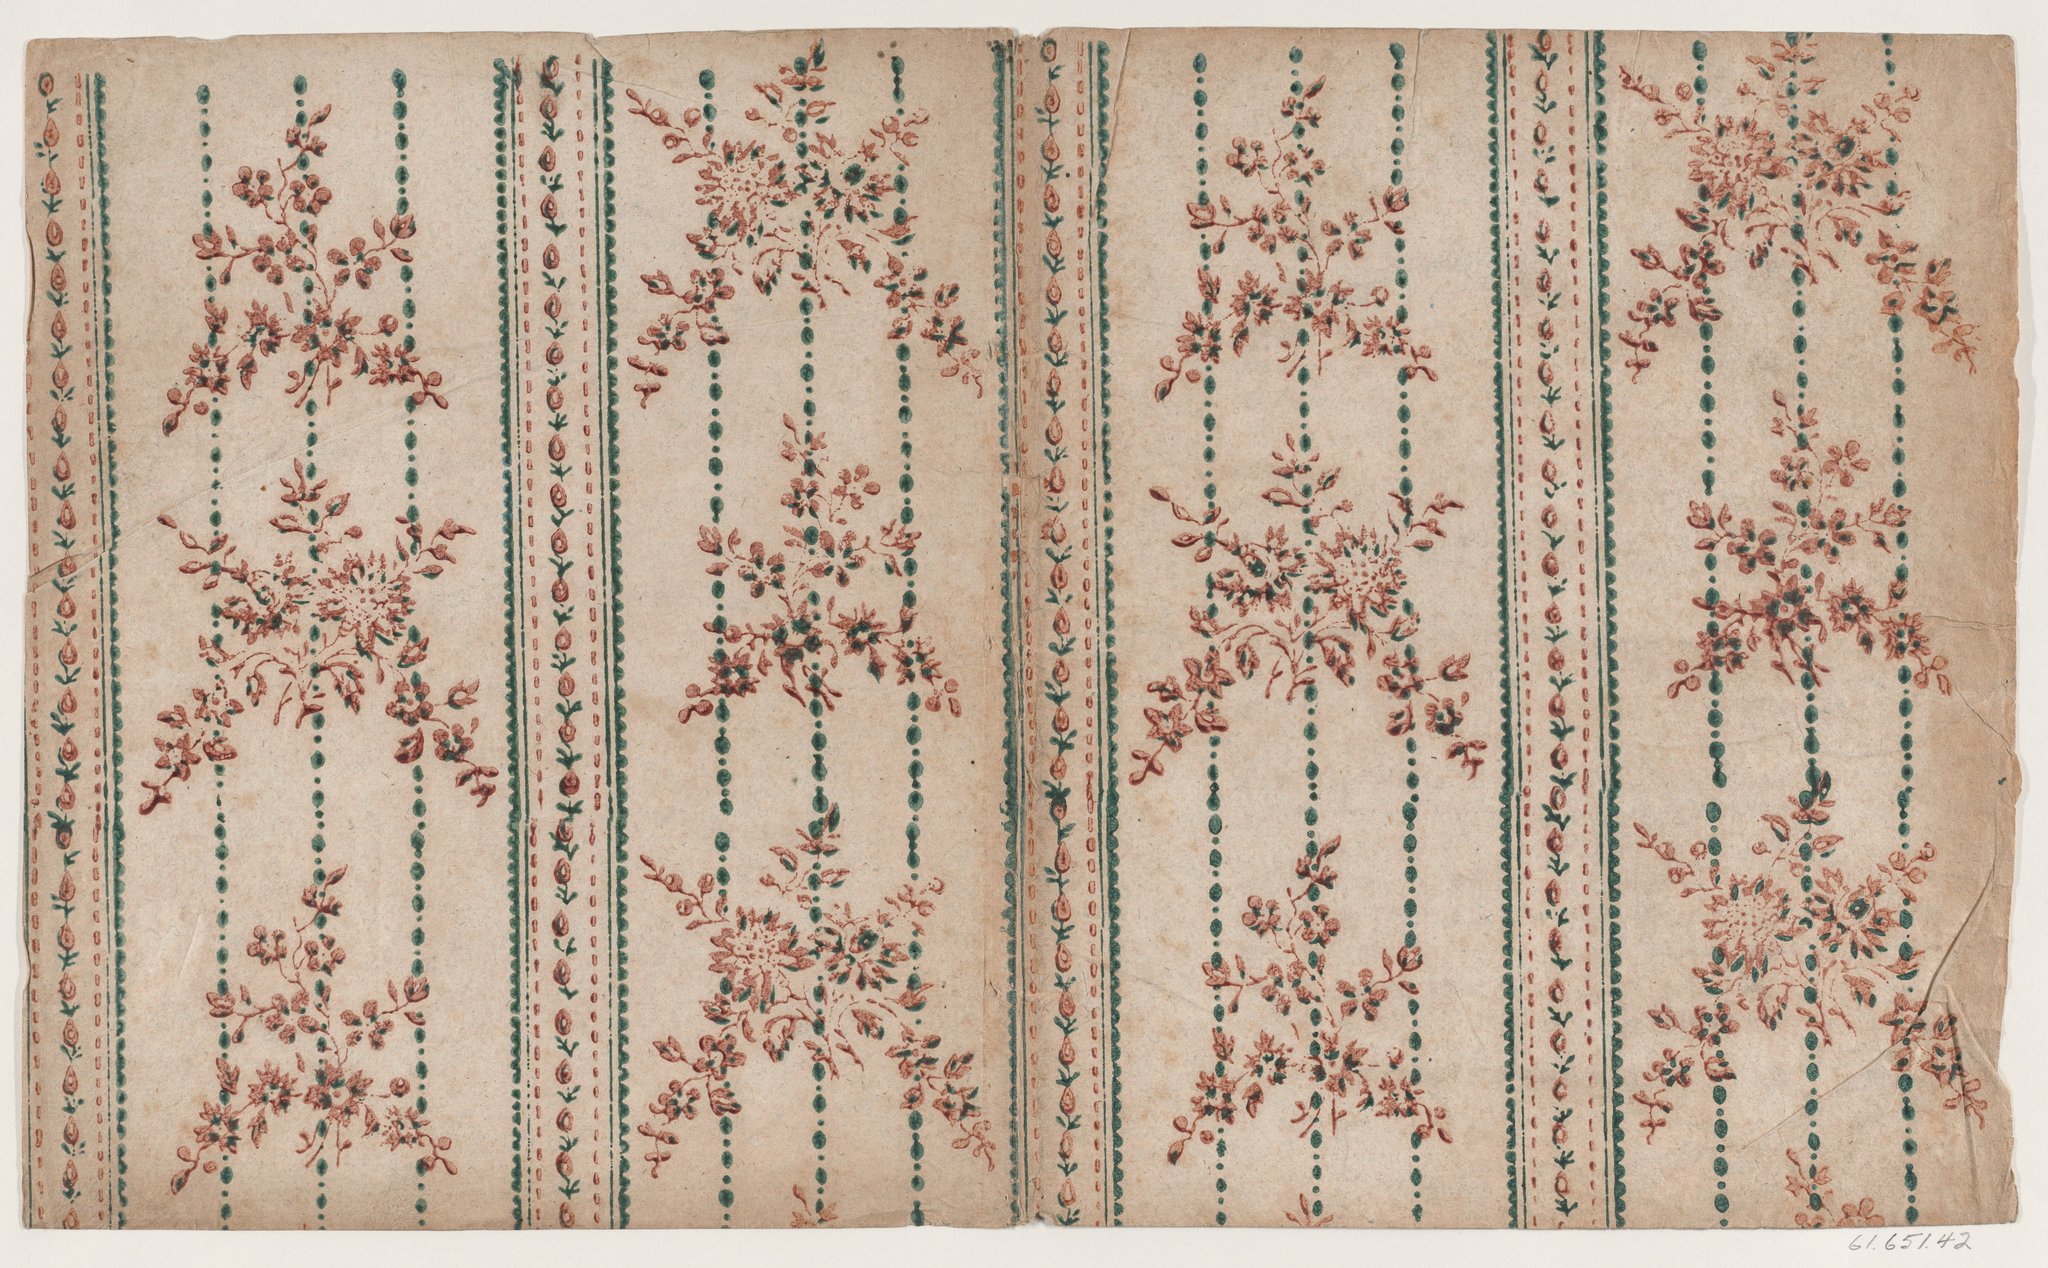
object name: print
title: Book cover with two borders with floral patterns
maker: Anonymous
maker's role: artist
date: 1801-1900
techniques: relief print